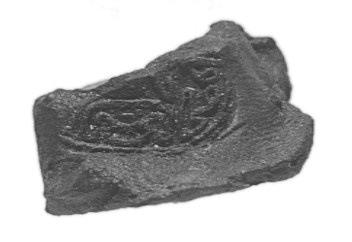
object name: sealing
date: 2030-1640 BCE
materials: clay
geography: egypt